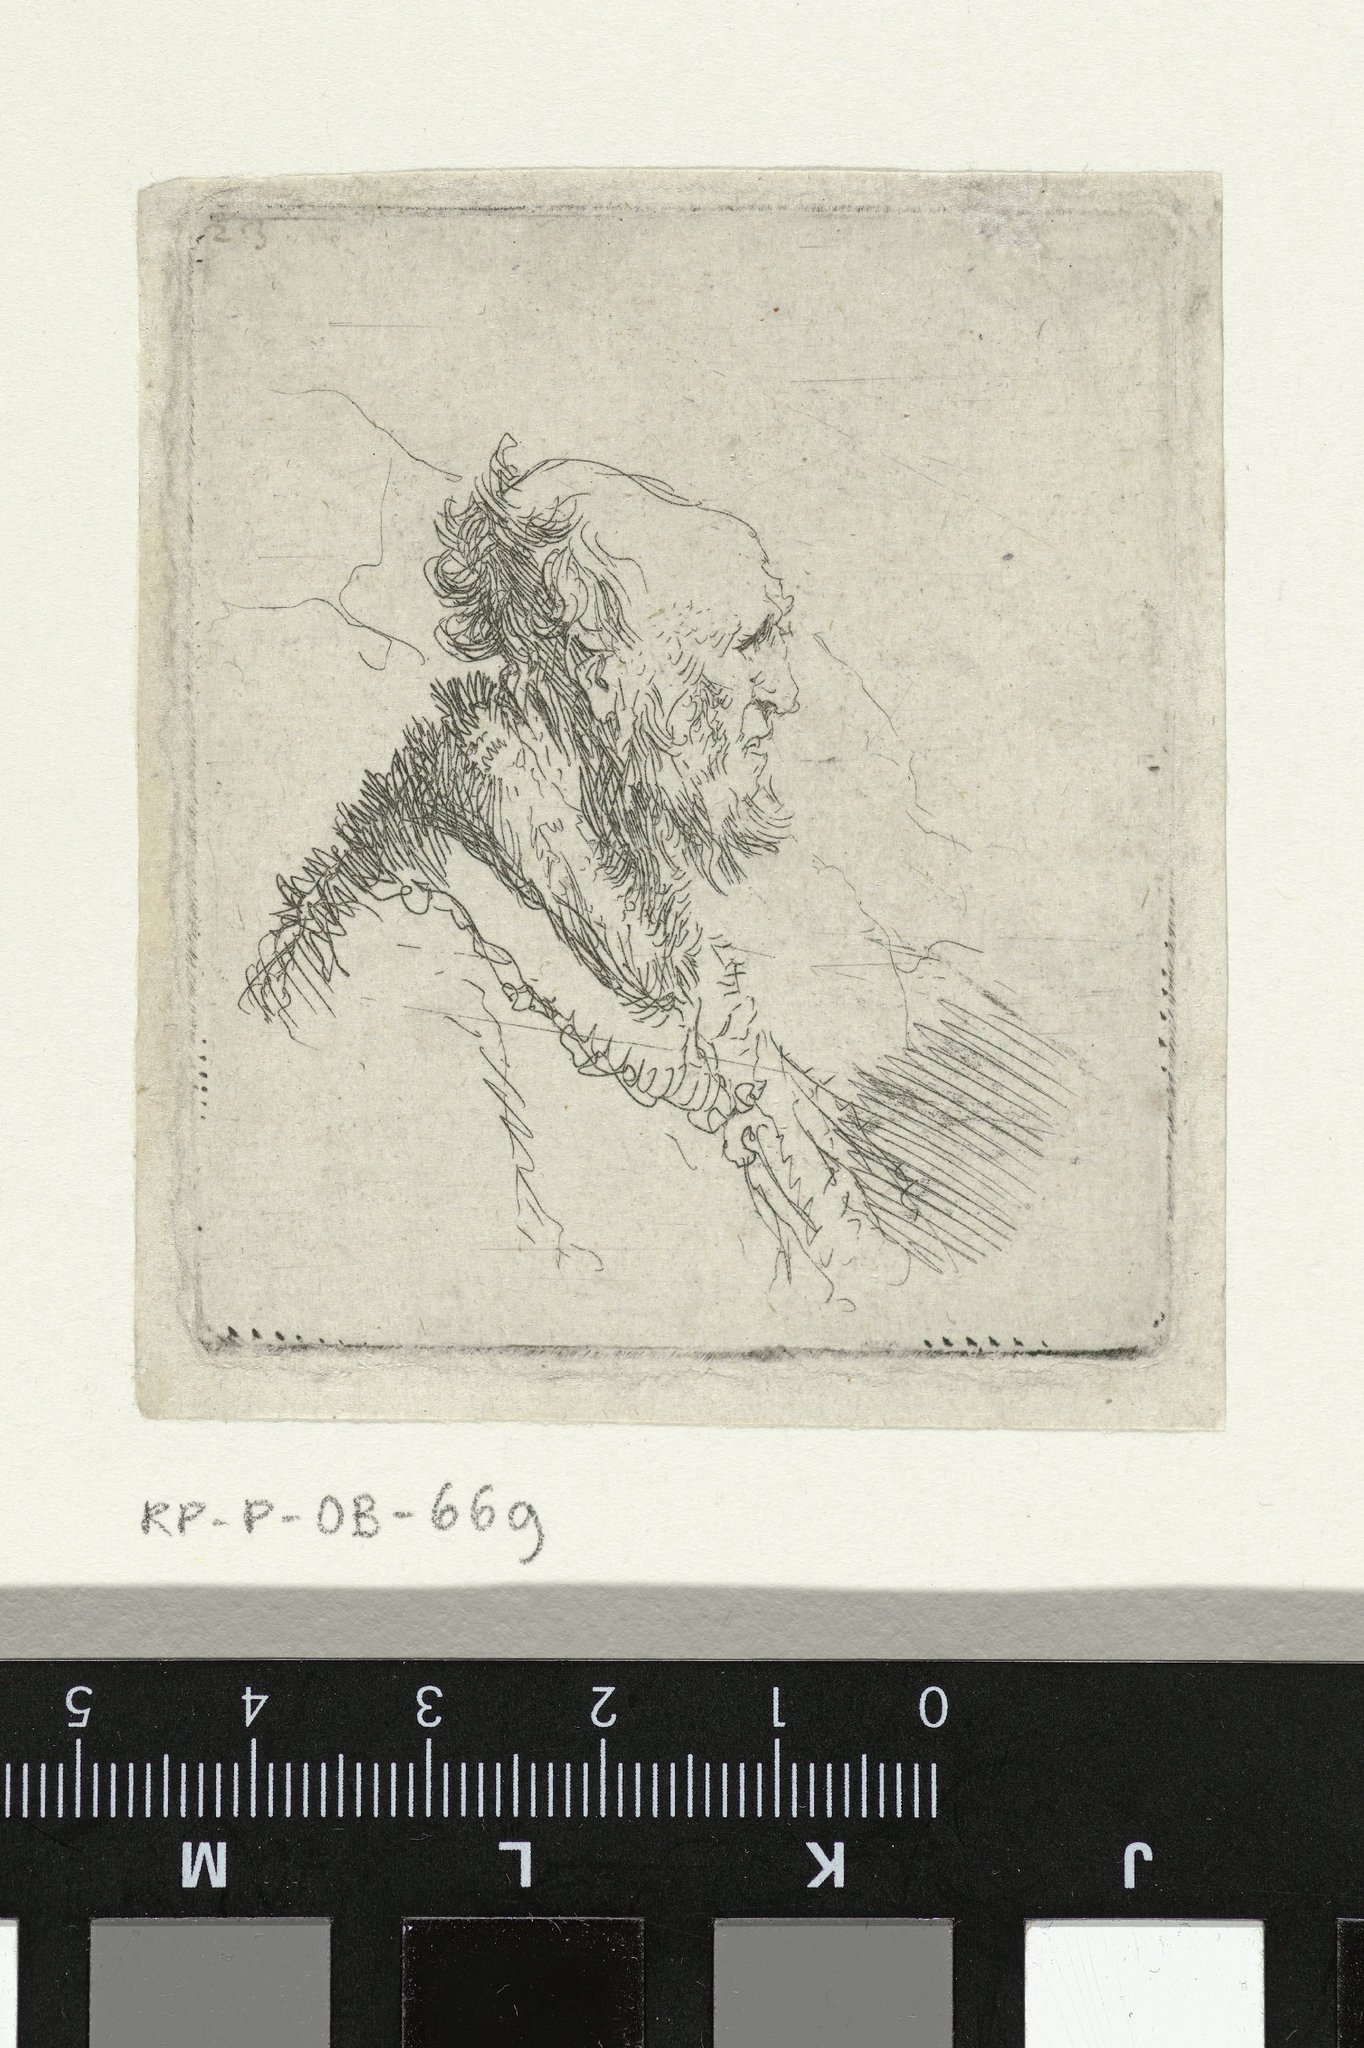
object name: print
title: Bald old man with a short beard, in profile right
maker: rembrandt van rijn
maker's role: draughtsman, painter, print maker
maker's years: 1606-1669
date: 1635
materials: paper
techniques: etching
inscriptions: collector's mark: Lugt 240, inscription: ‘23’